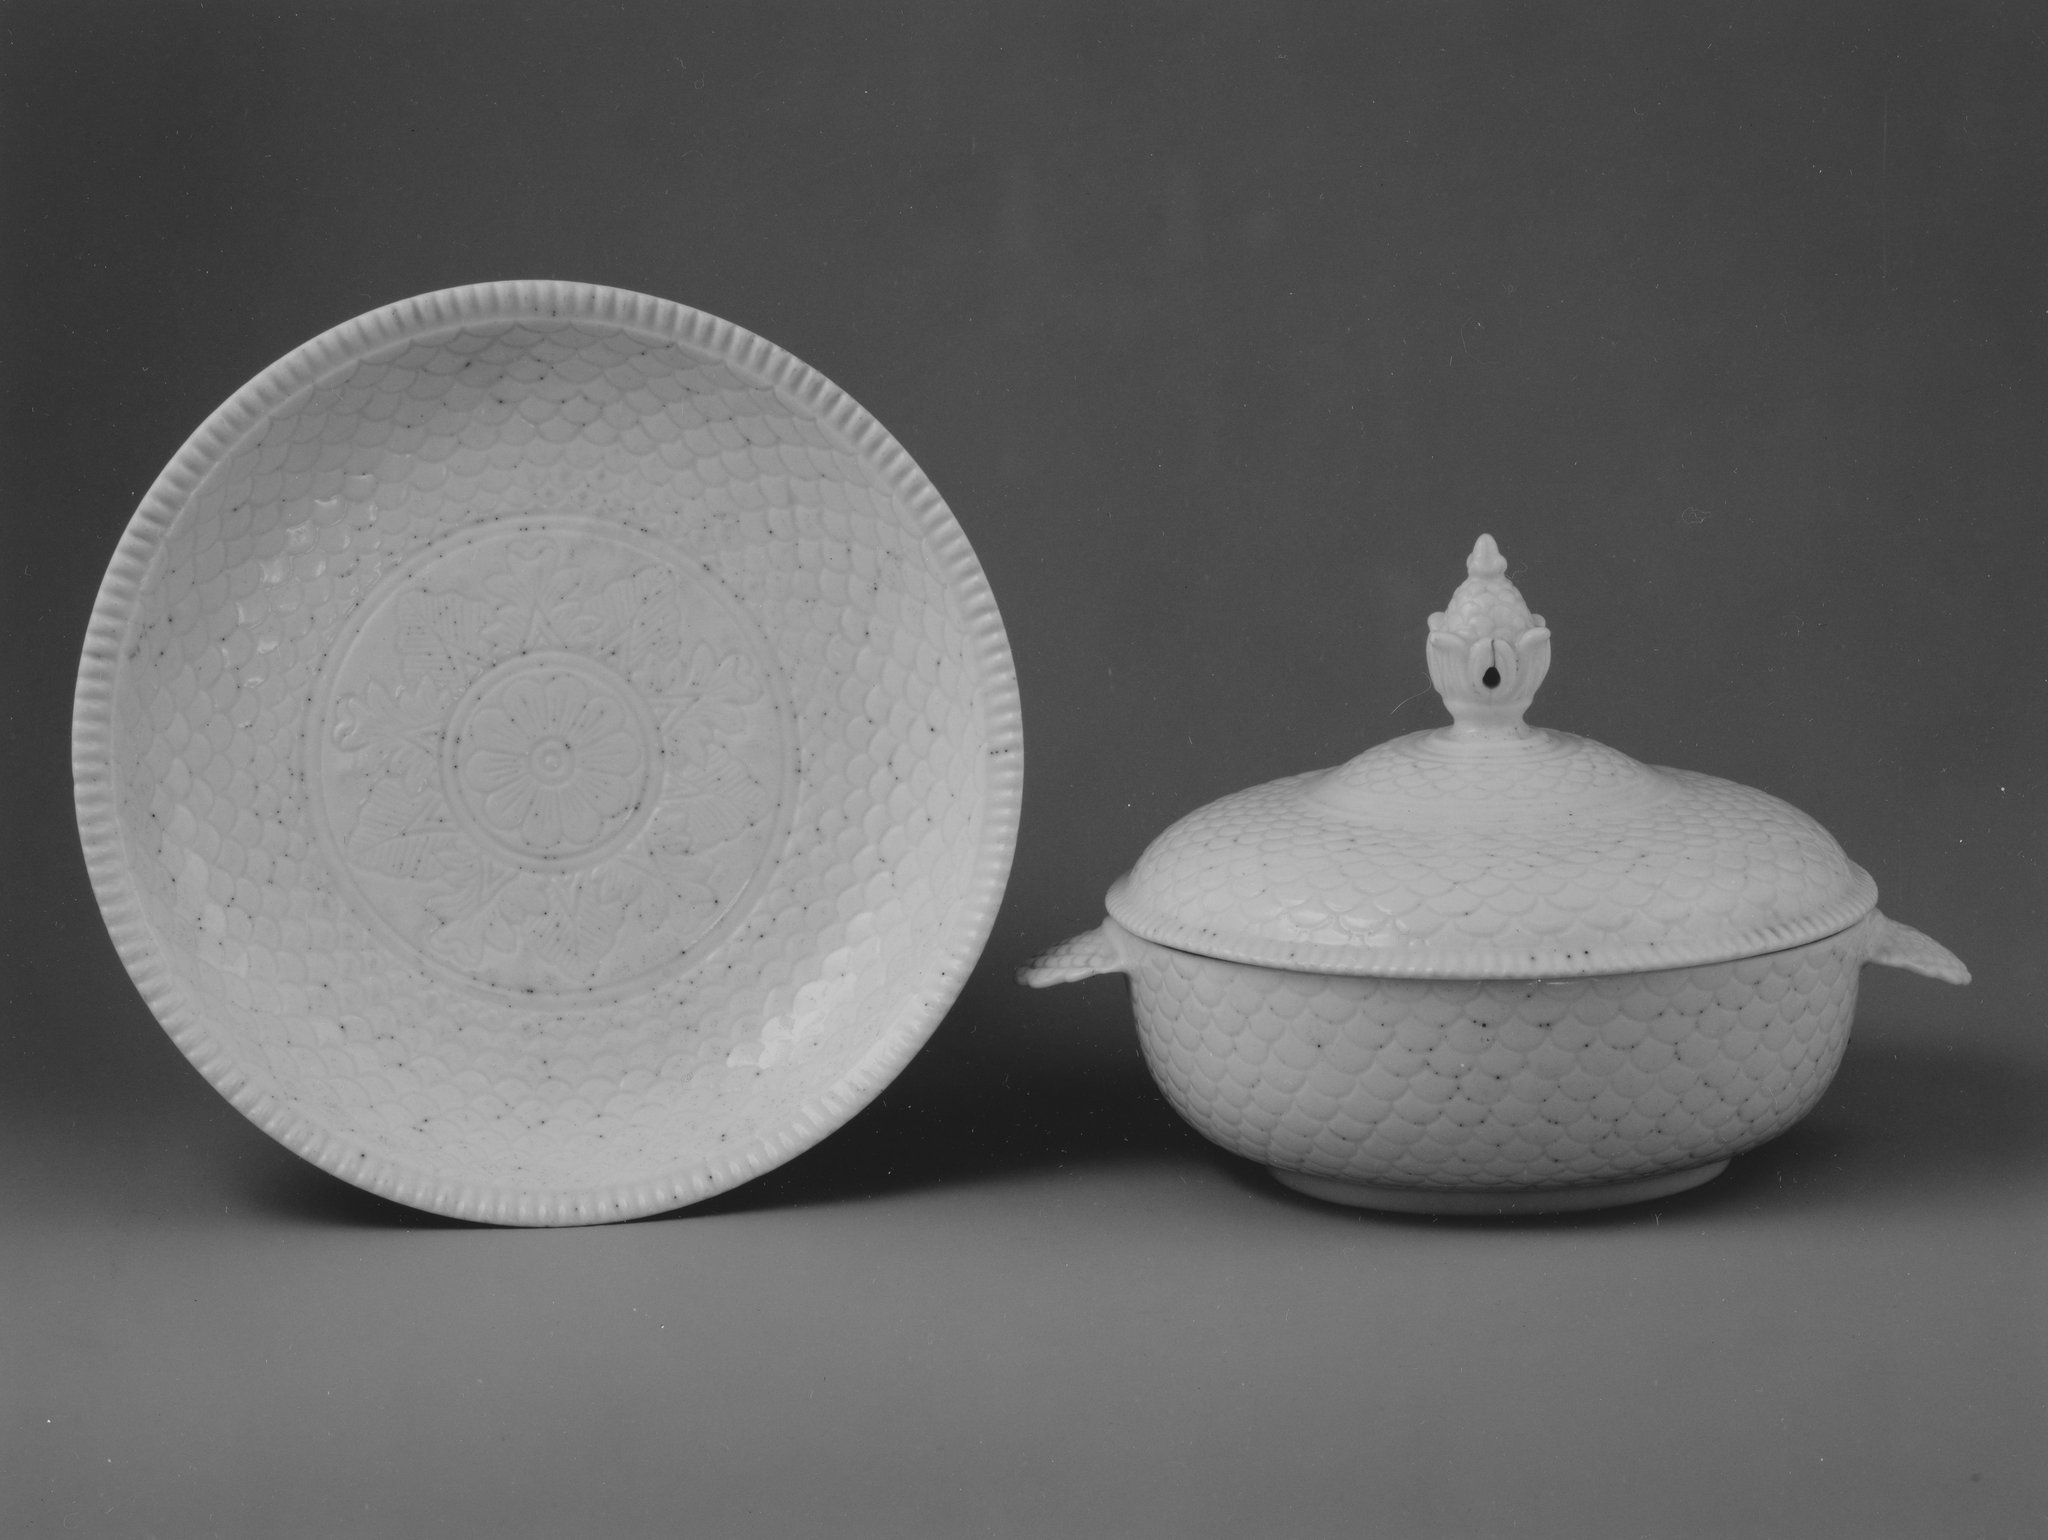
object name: bowl with cover and tray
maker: saint-cloud factory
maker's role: factory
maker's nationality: french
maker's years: 1693-1766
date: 1720-1730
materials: soft paste porcelain